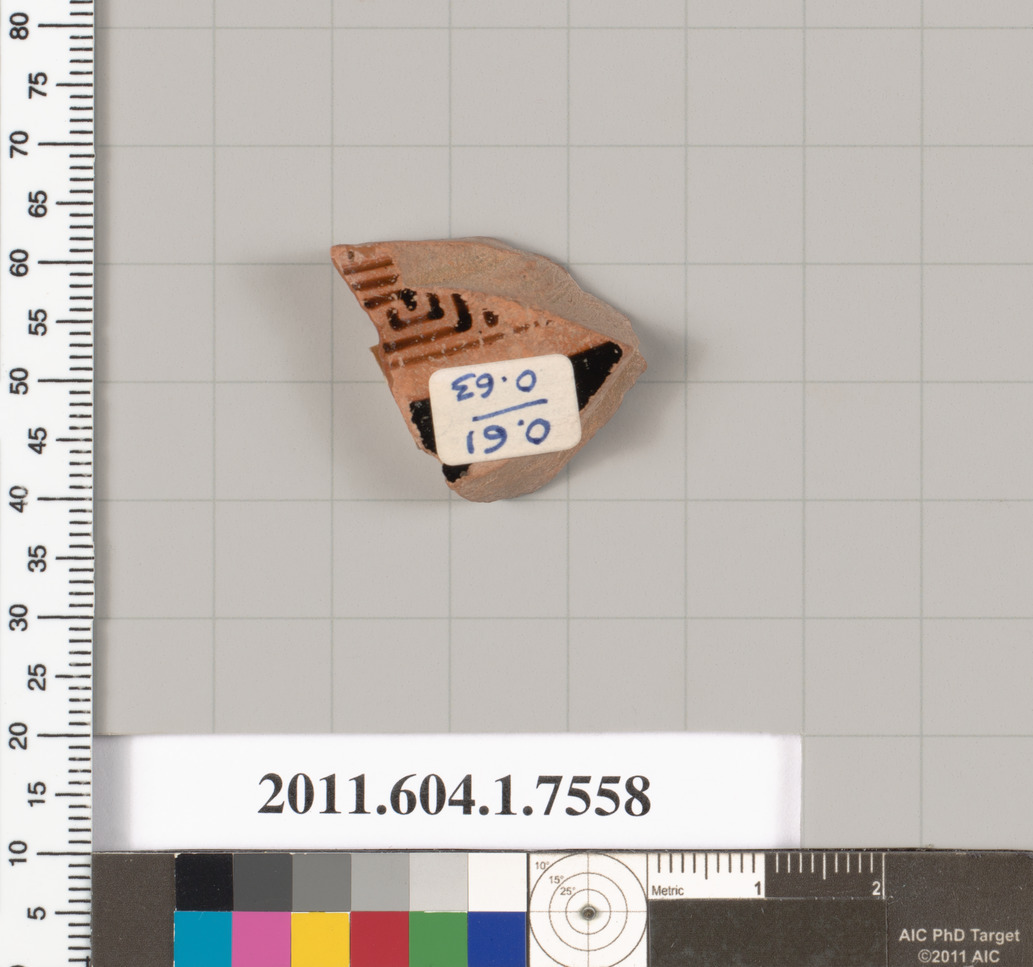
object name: kylix fragment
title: Terracotta fragment of a kylix (drinking cup)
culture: greek, attic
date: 460-450 BCE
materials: terracotta